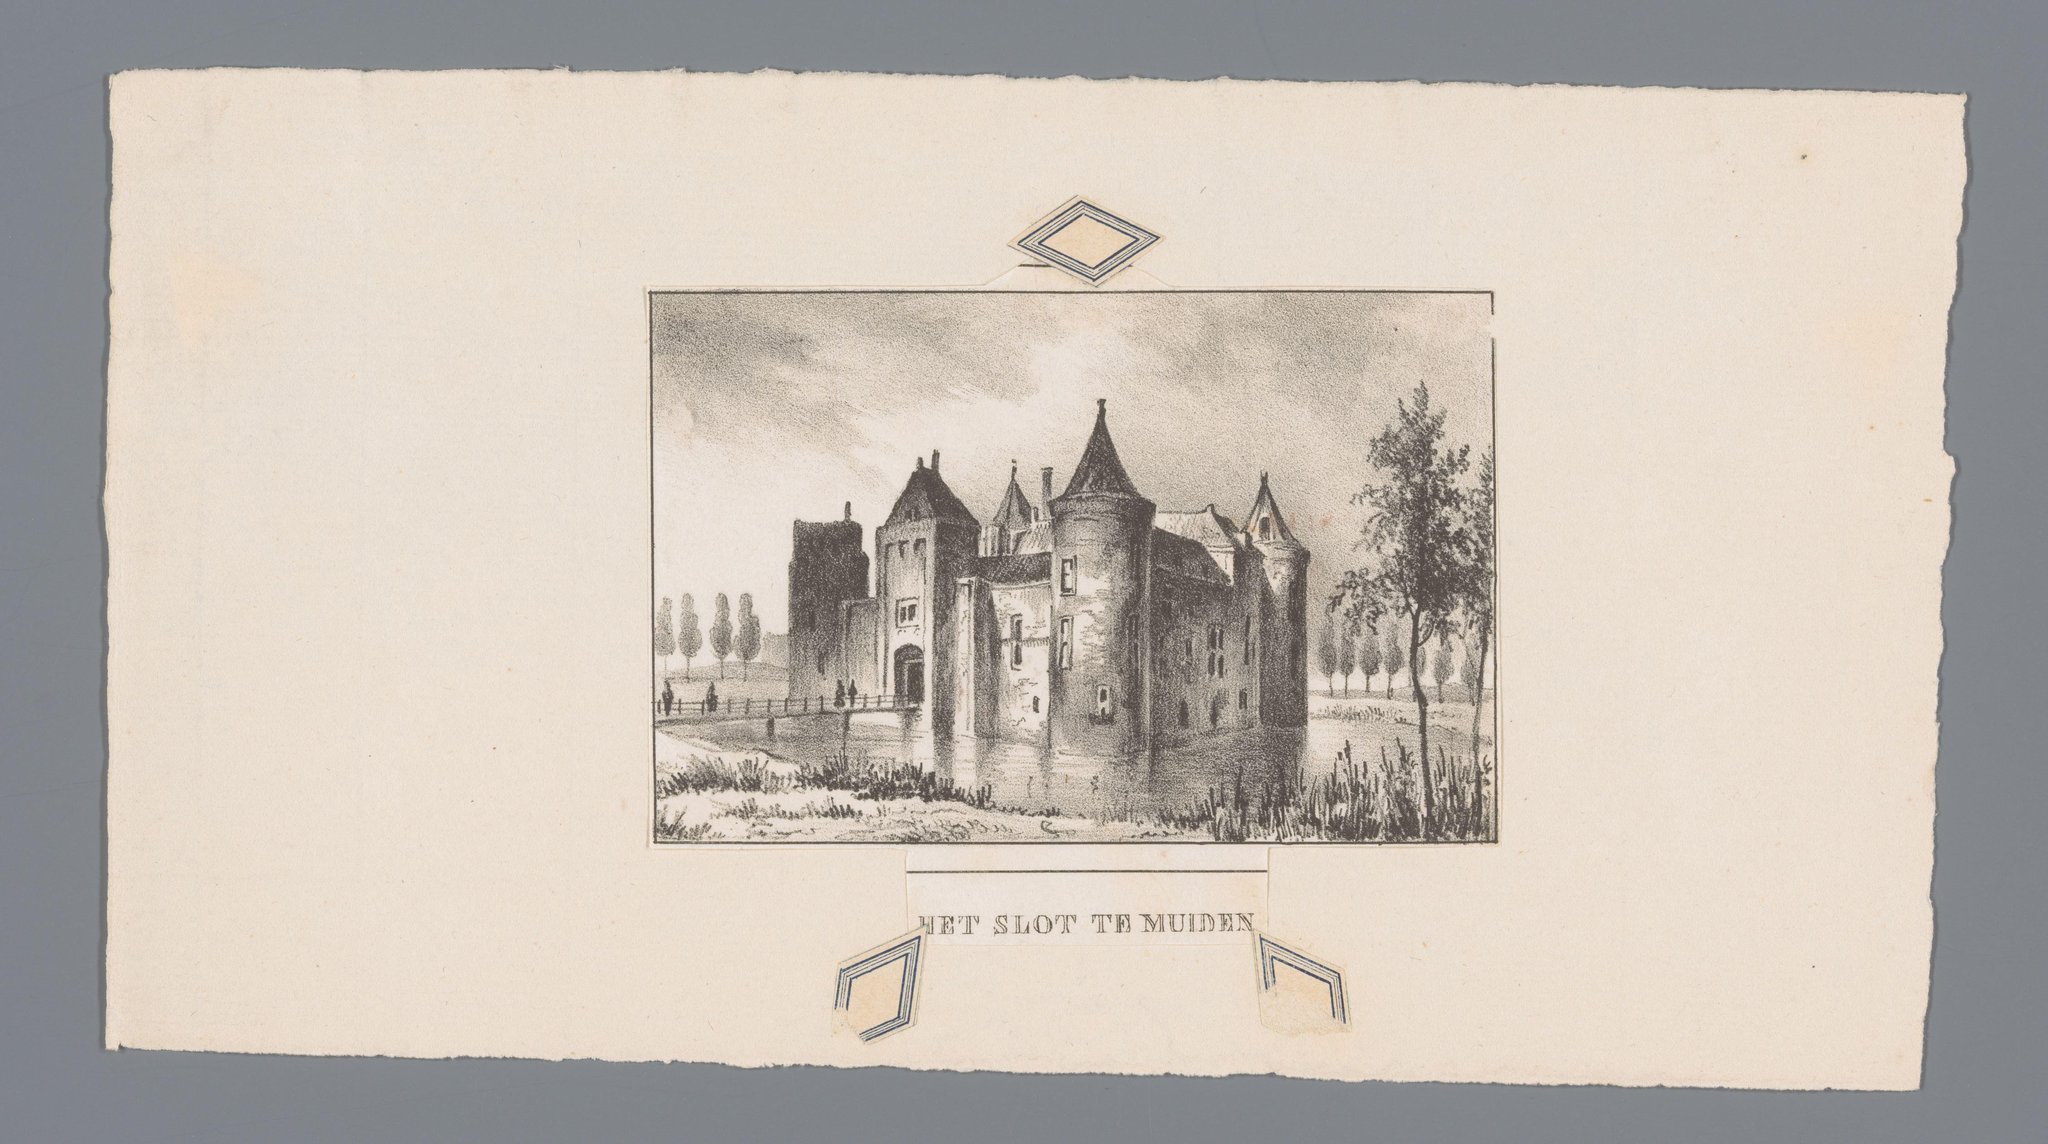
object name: print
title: Gezicht op het Muiderslot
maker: Anonymous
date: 1800-1900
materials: paper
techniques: lithograph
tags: castle